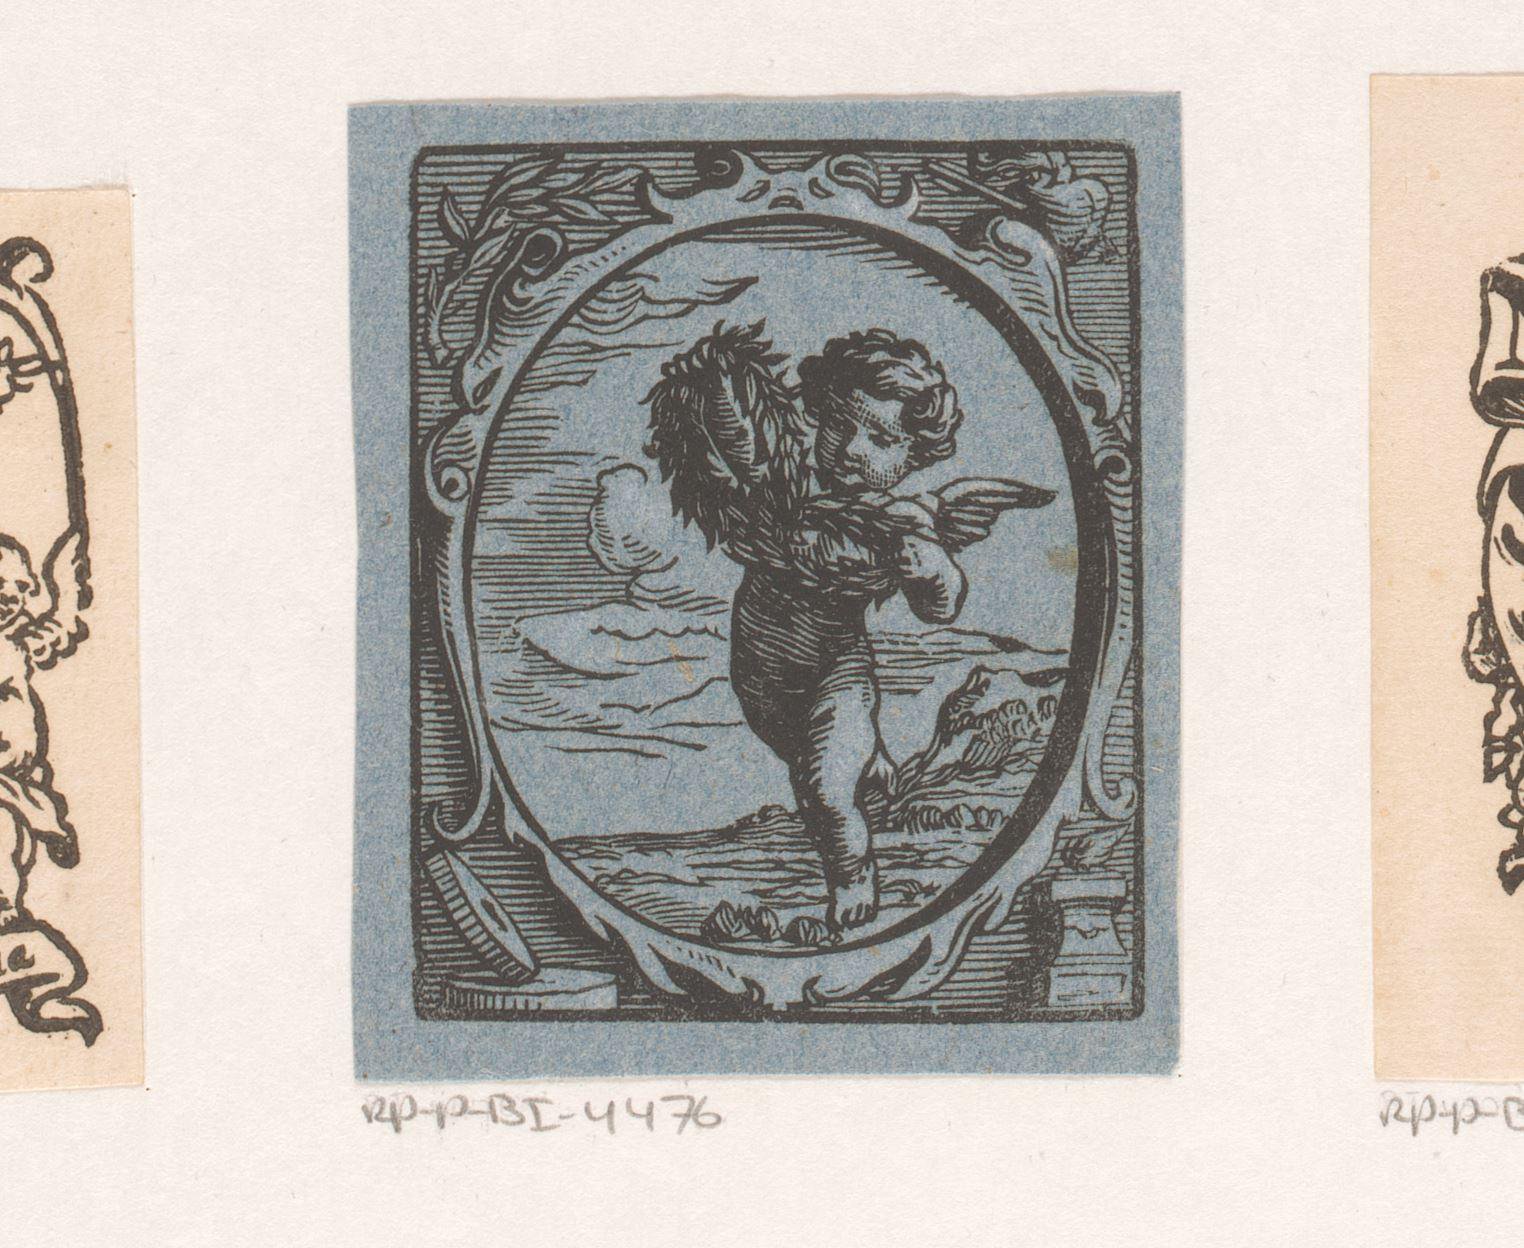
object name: print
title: Vignet met een putto met een lauwerkrans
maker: Anonymous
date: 1600-1699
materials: paper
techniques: woodcut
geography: netherlands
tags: garland, wreath, vignette, cupids: 'amores', 'amoretti', 'putti'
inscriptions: collector's mark: Lugt 240